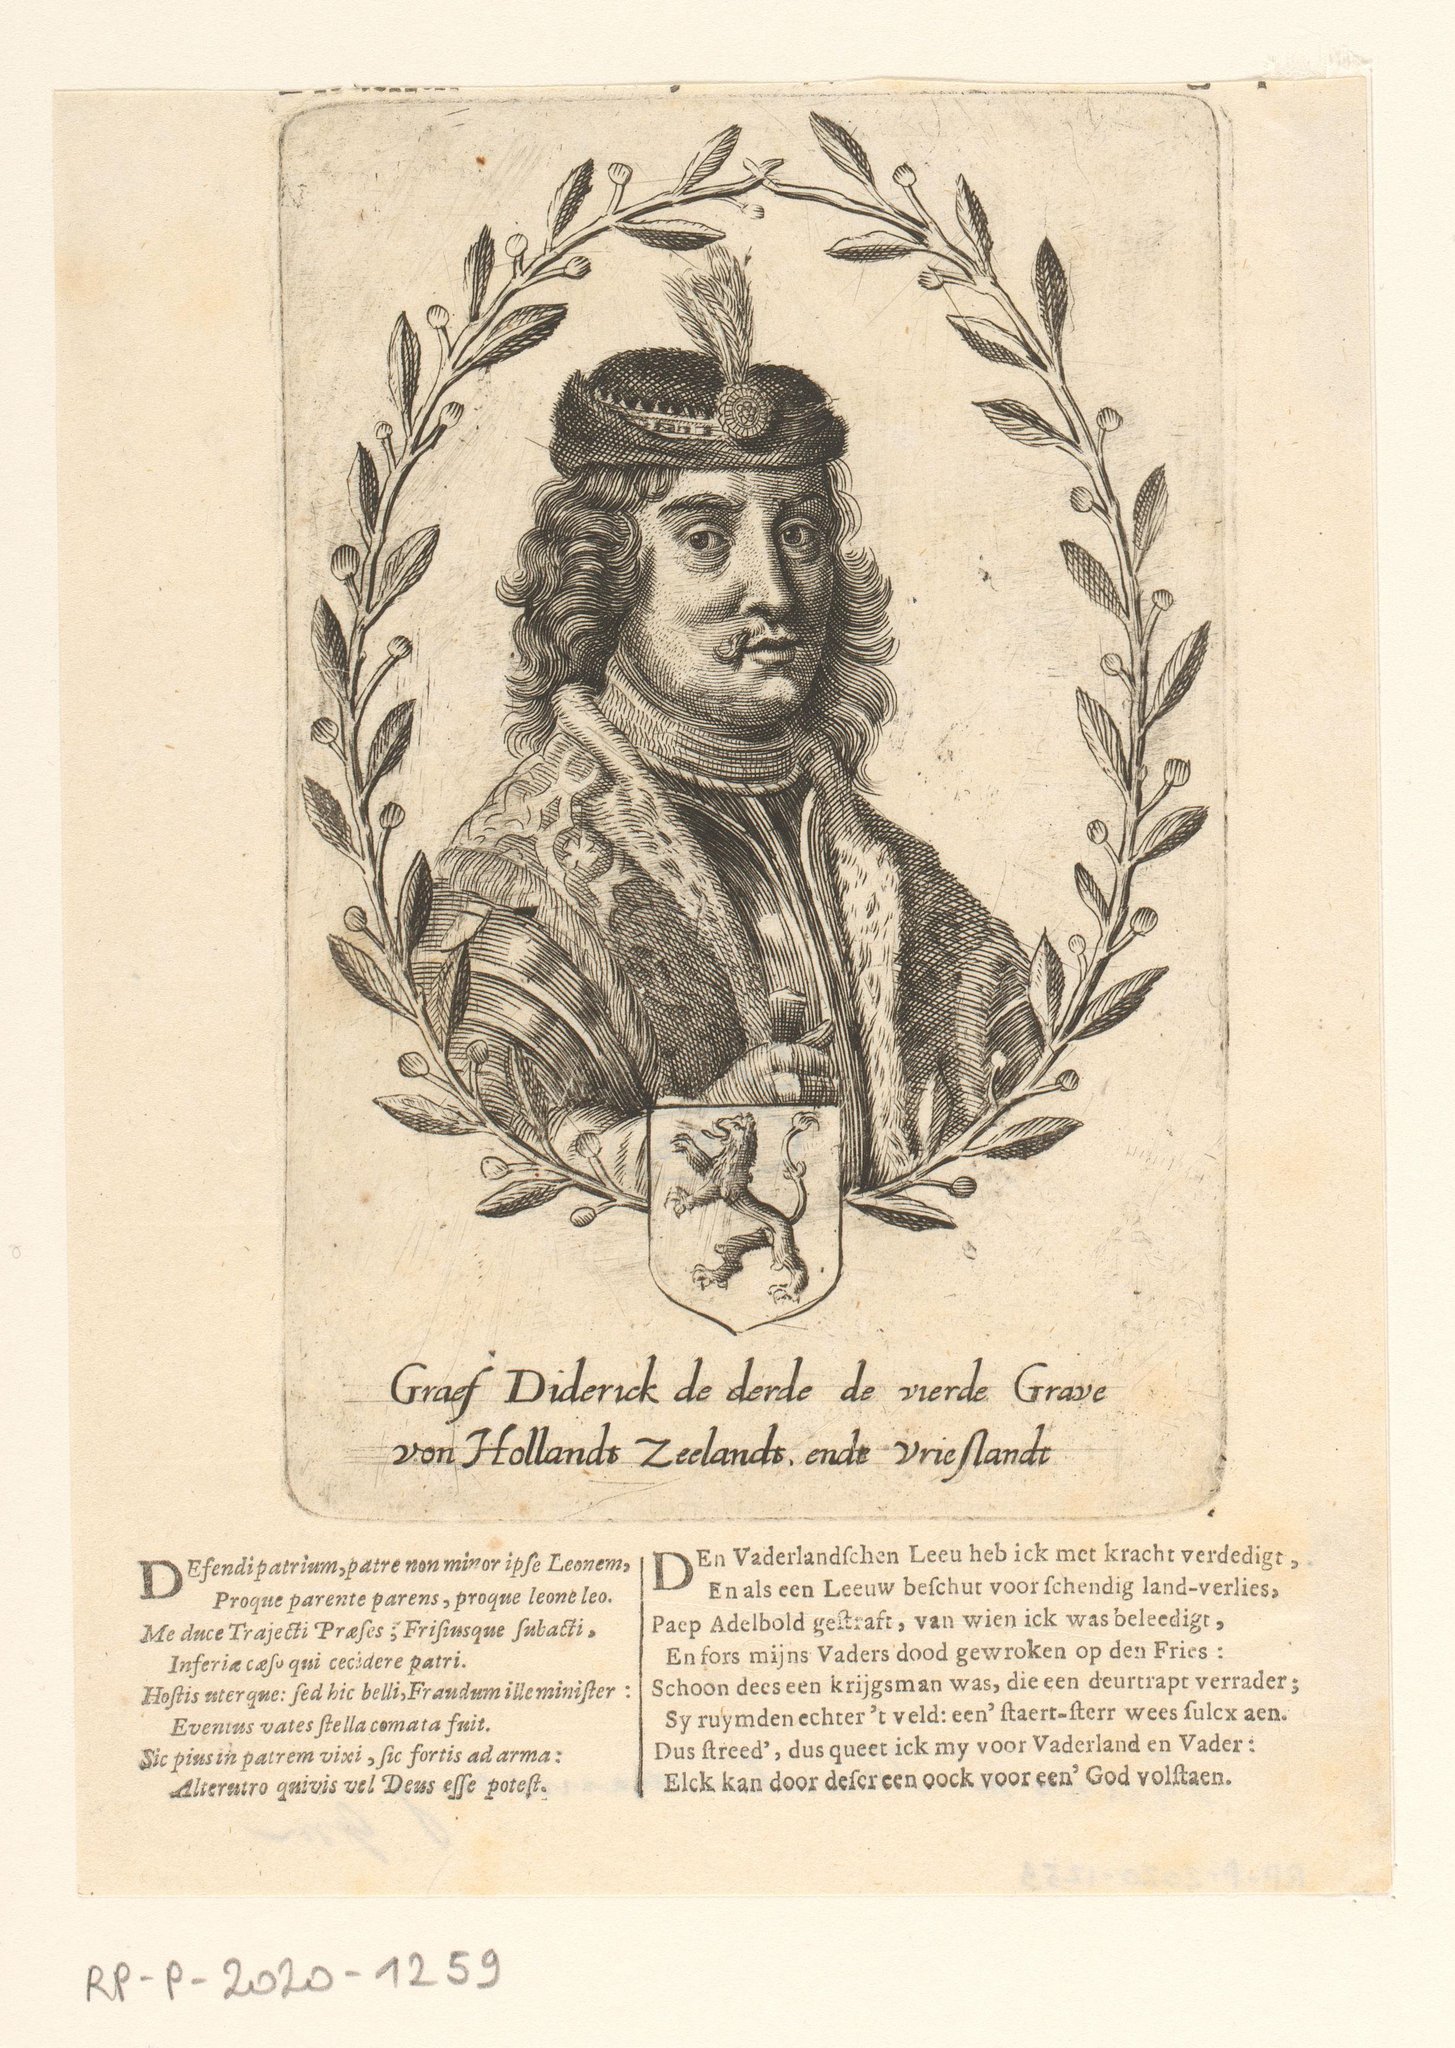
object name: book illustration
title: Portret van Dirk III, graaf van Holland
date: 1677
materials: paper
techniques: engraving, etching, letterpress printing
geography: the hague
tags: historical persons, ruler, sovereign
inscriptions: collector's mark: Lugt 964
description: Prent uit: Scriverius, Petrus. Hollandsche, Zeelandsche ende Vriesche chronyck. Den Haag: Jasper Doll en Johan Veely, 1677, p. 48.